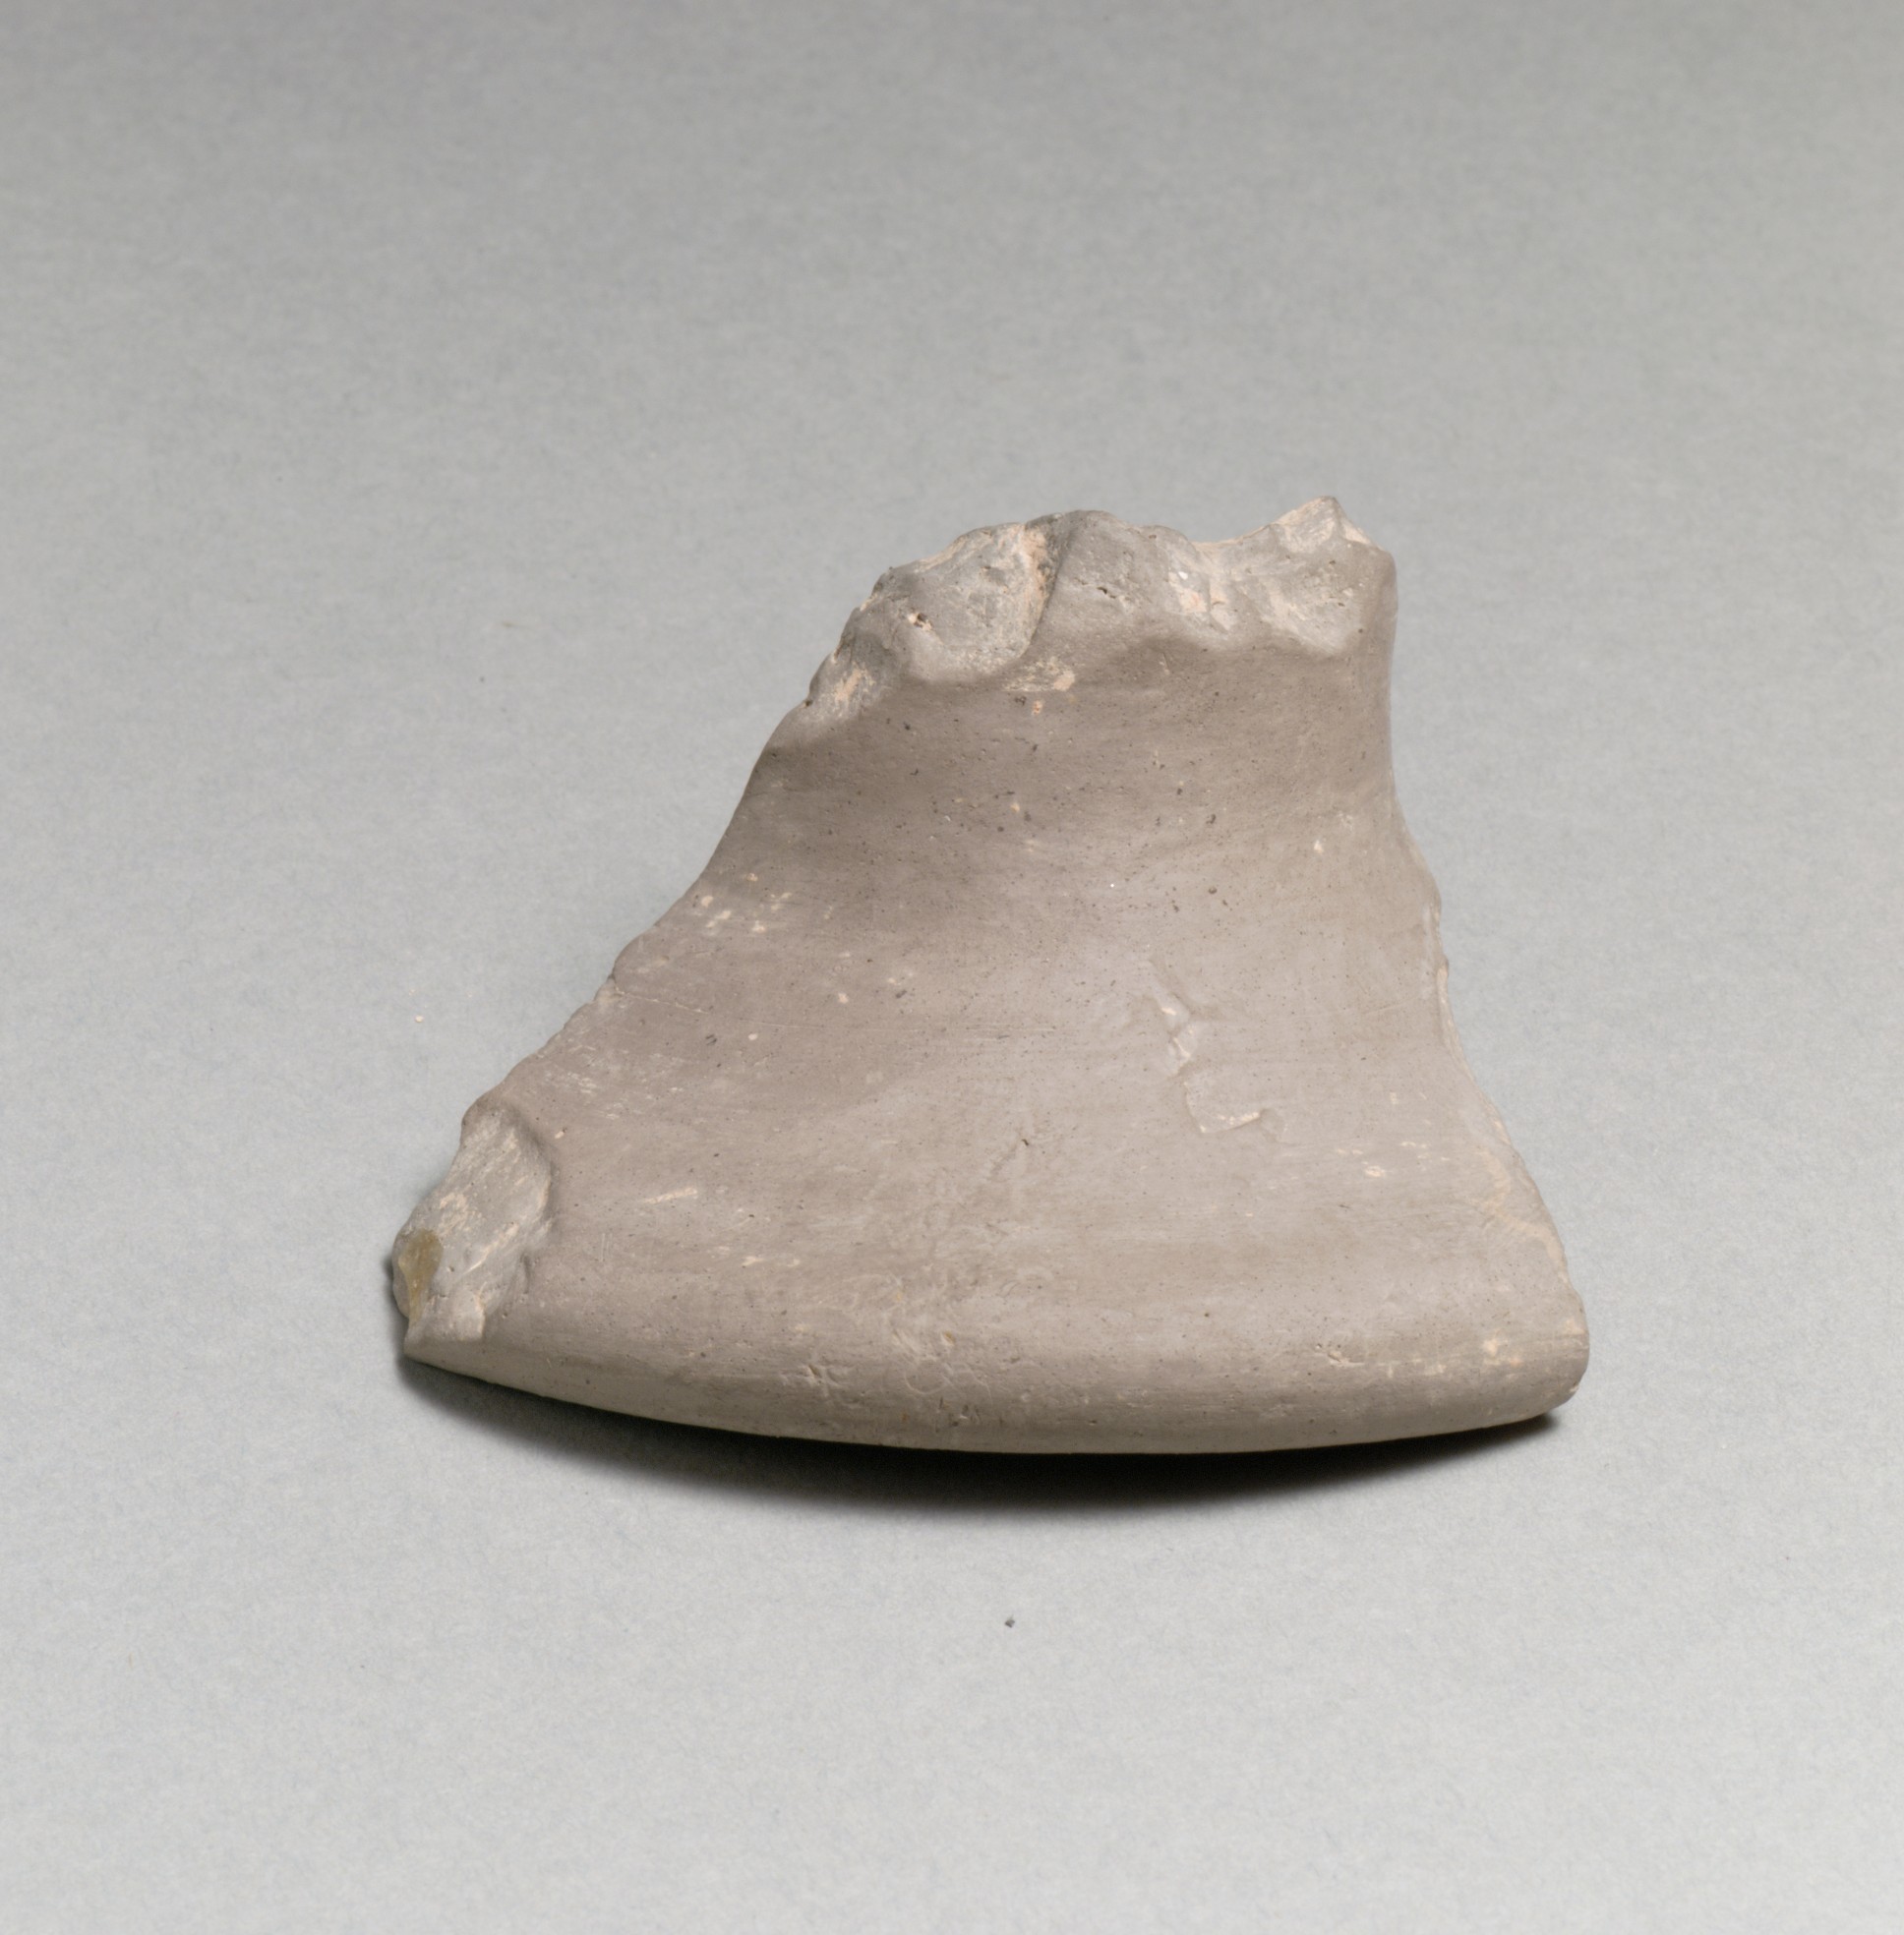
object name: vase fragment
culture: minoan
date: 2600-2000 BCE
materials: terracotta